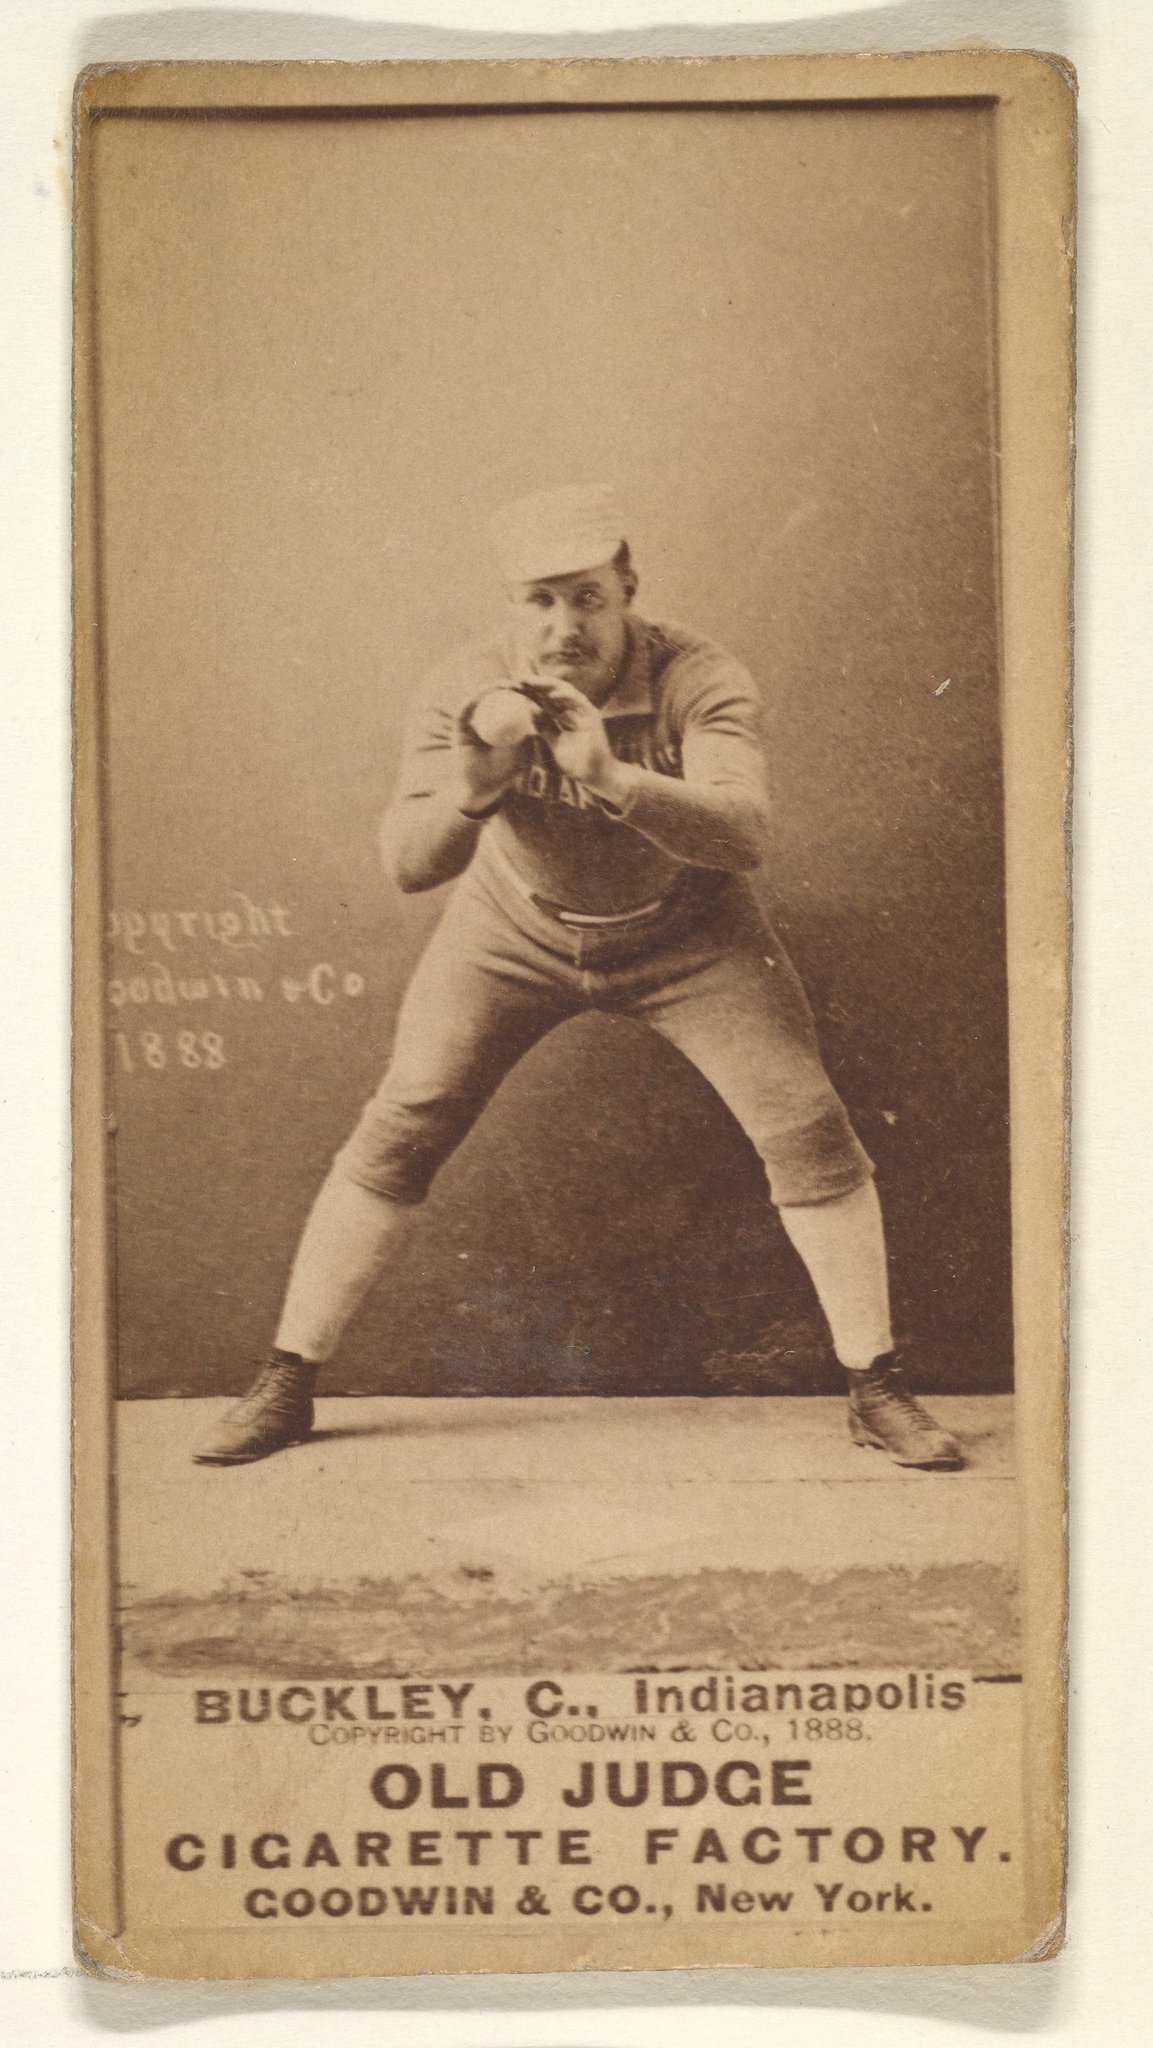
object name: baseball card, photograph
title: Buckley, Catcher, Indianapolis, from the Old Judge series (N172) for Old Judge Cigarettes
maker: goodwin & company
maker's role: publisher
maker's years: 1850-1950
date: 1888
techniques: albumen silver print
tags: men,portraits,baseball,athletes